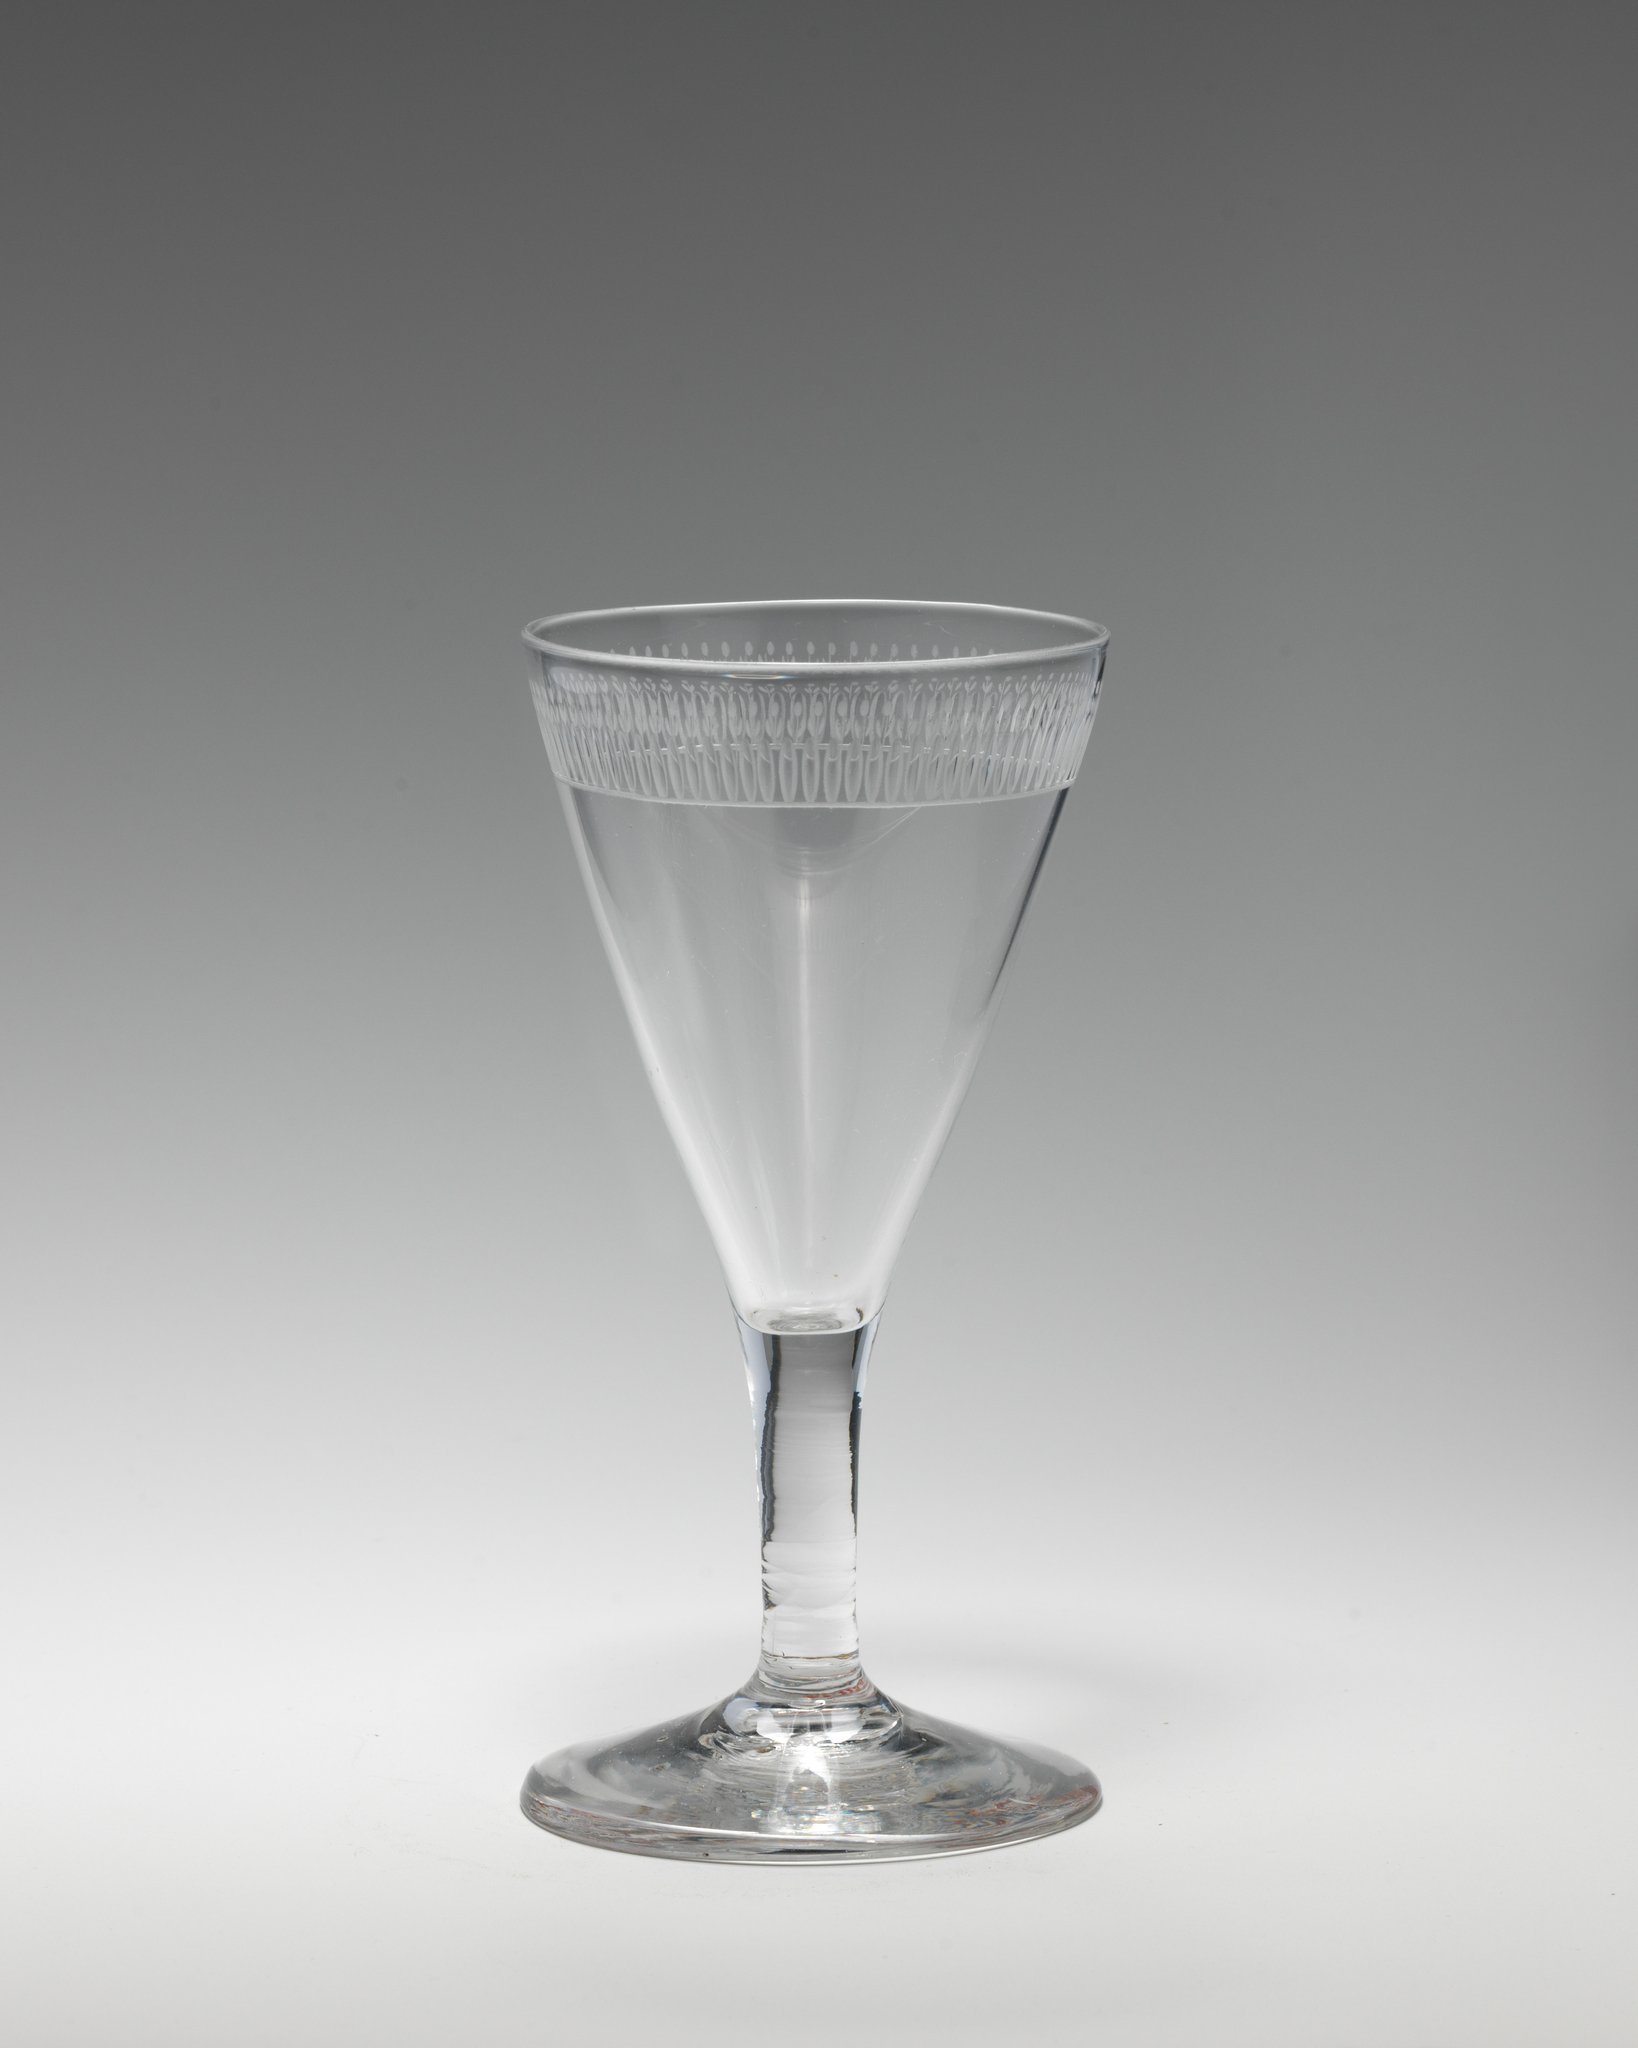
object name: wineglass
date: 1800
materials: glass